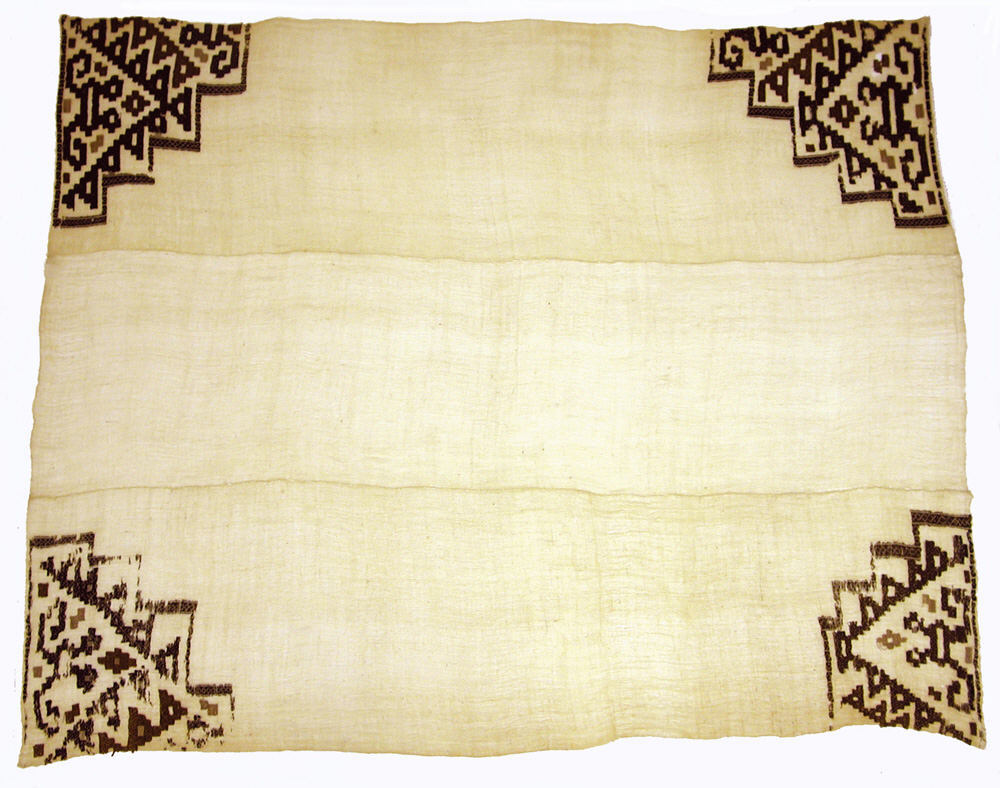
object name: mantle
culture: chimú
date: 1101-1500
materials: animal fiber, cotton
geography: peru